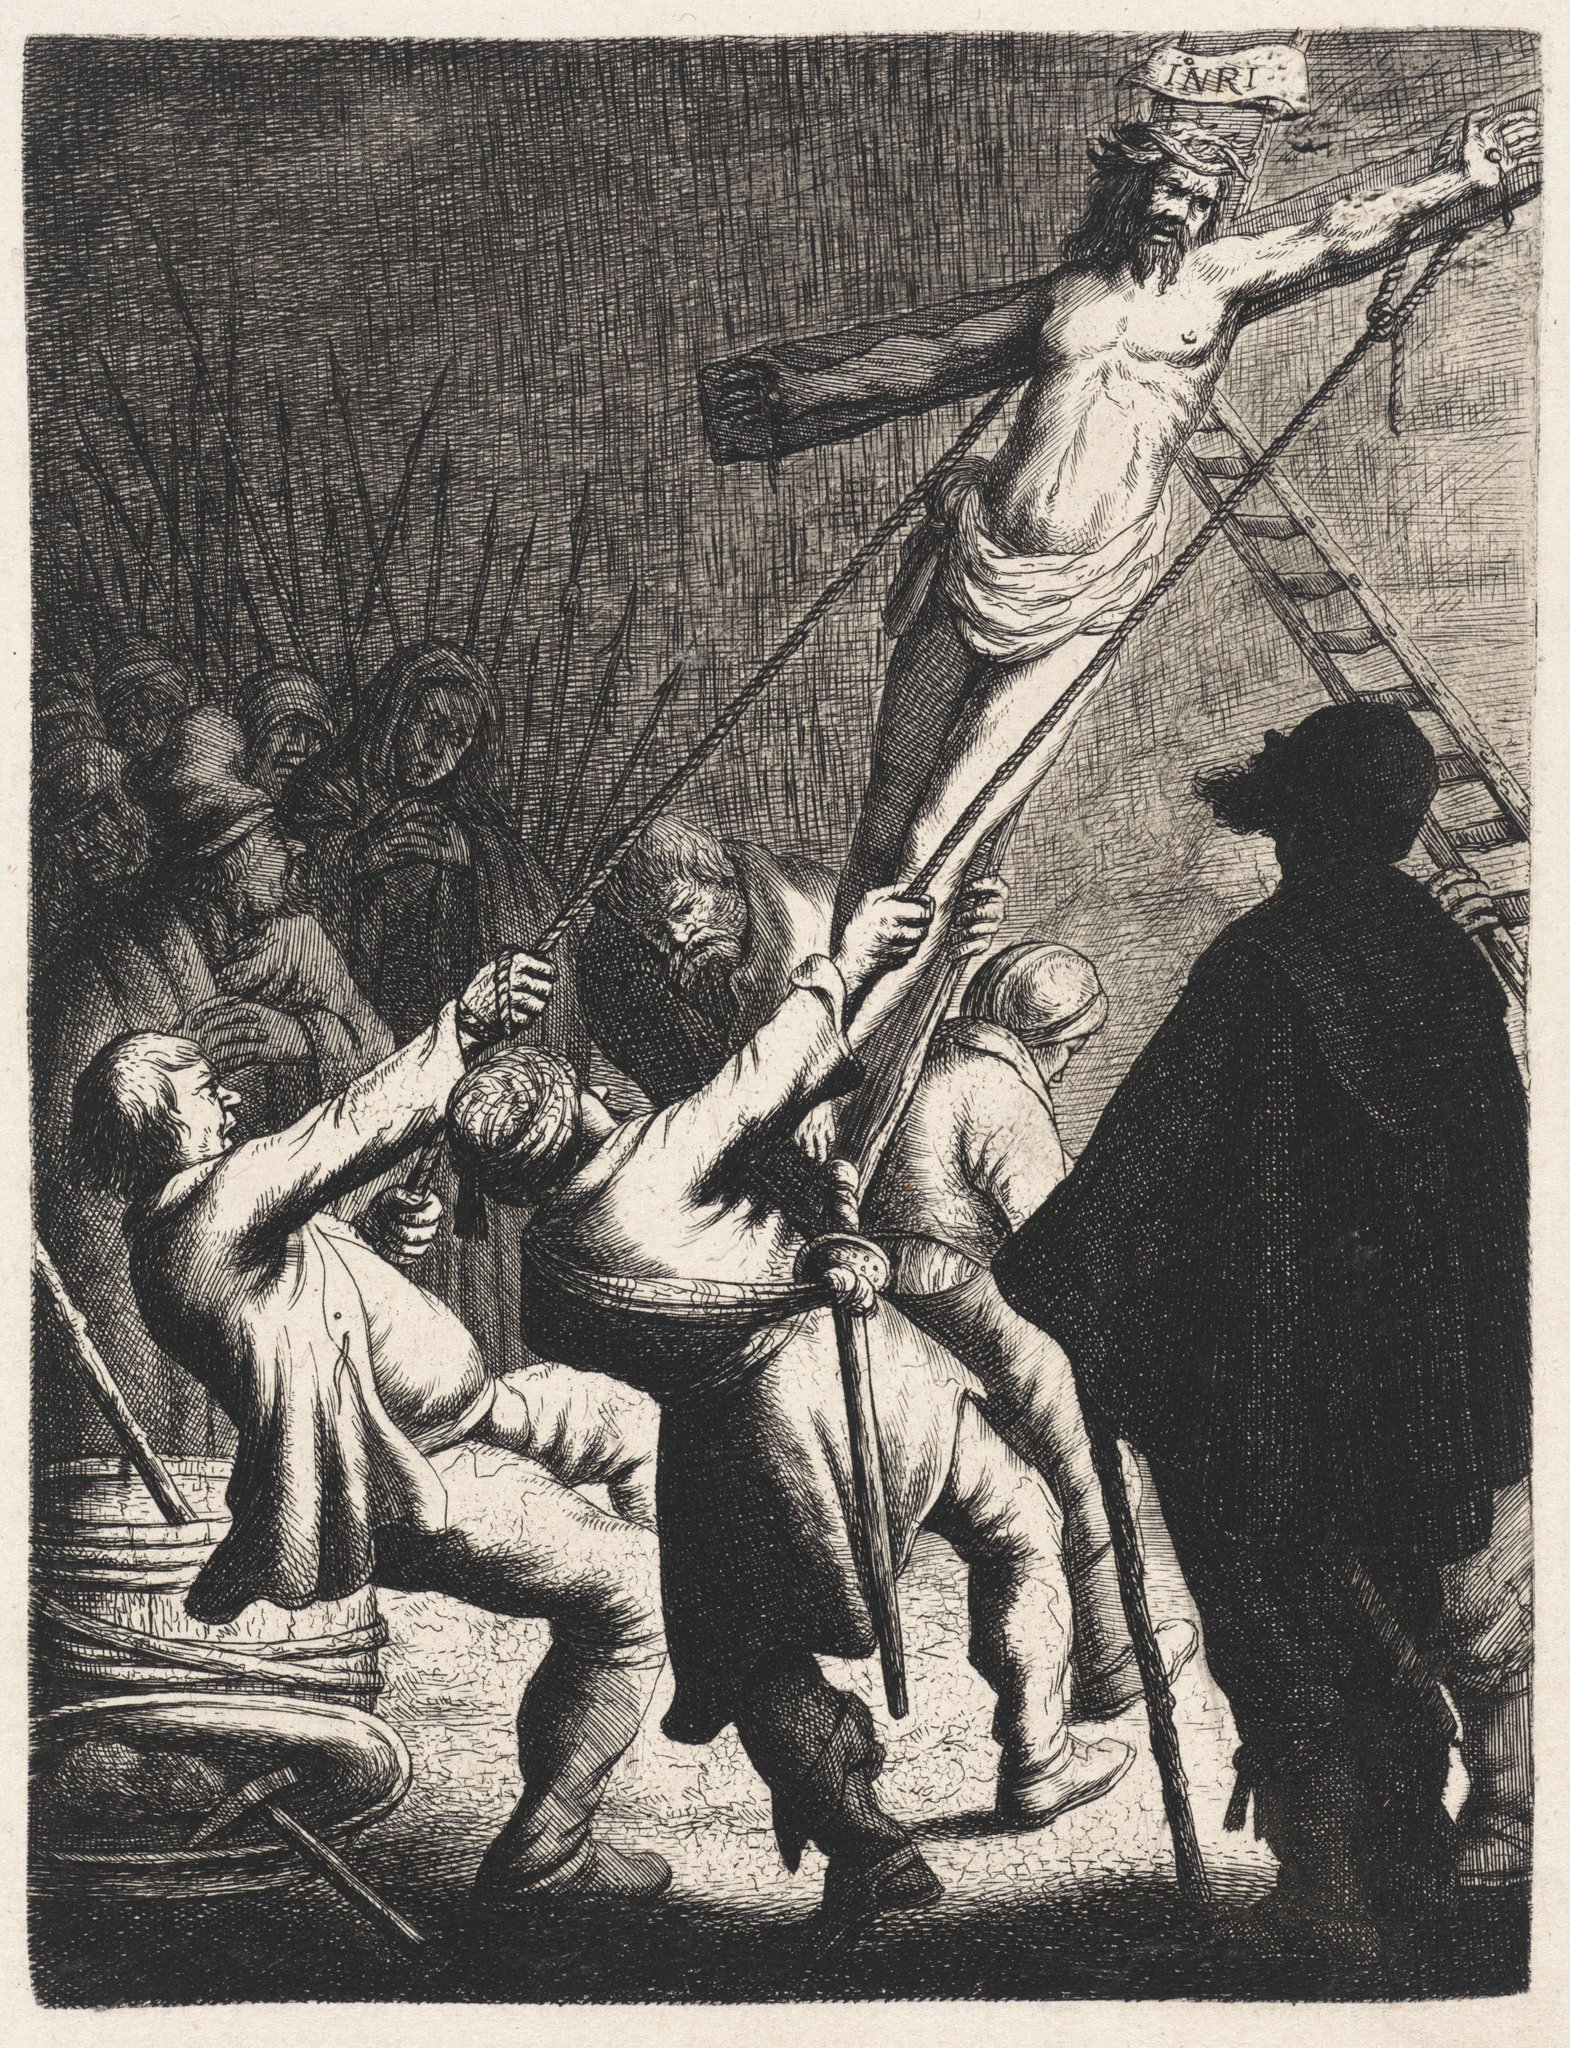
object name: print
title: Oprichting van het kruis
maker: jan gillisz. van vliet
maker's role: draughtsman, painter, print maker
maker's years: 1600-1668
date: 1628-1637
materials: paper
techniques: engraving, etching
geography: leiden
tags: raising of the cross to which christ is nailed already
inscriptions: collector's mark: Lugt 240